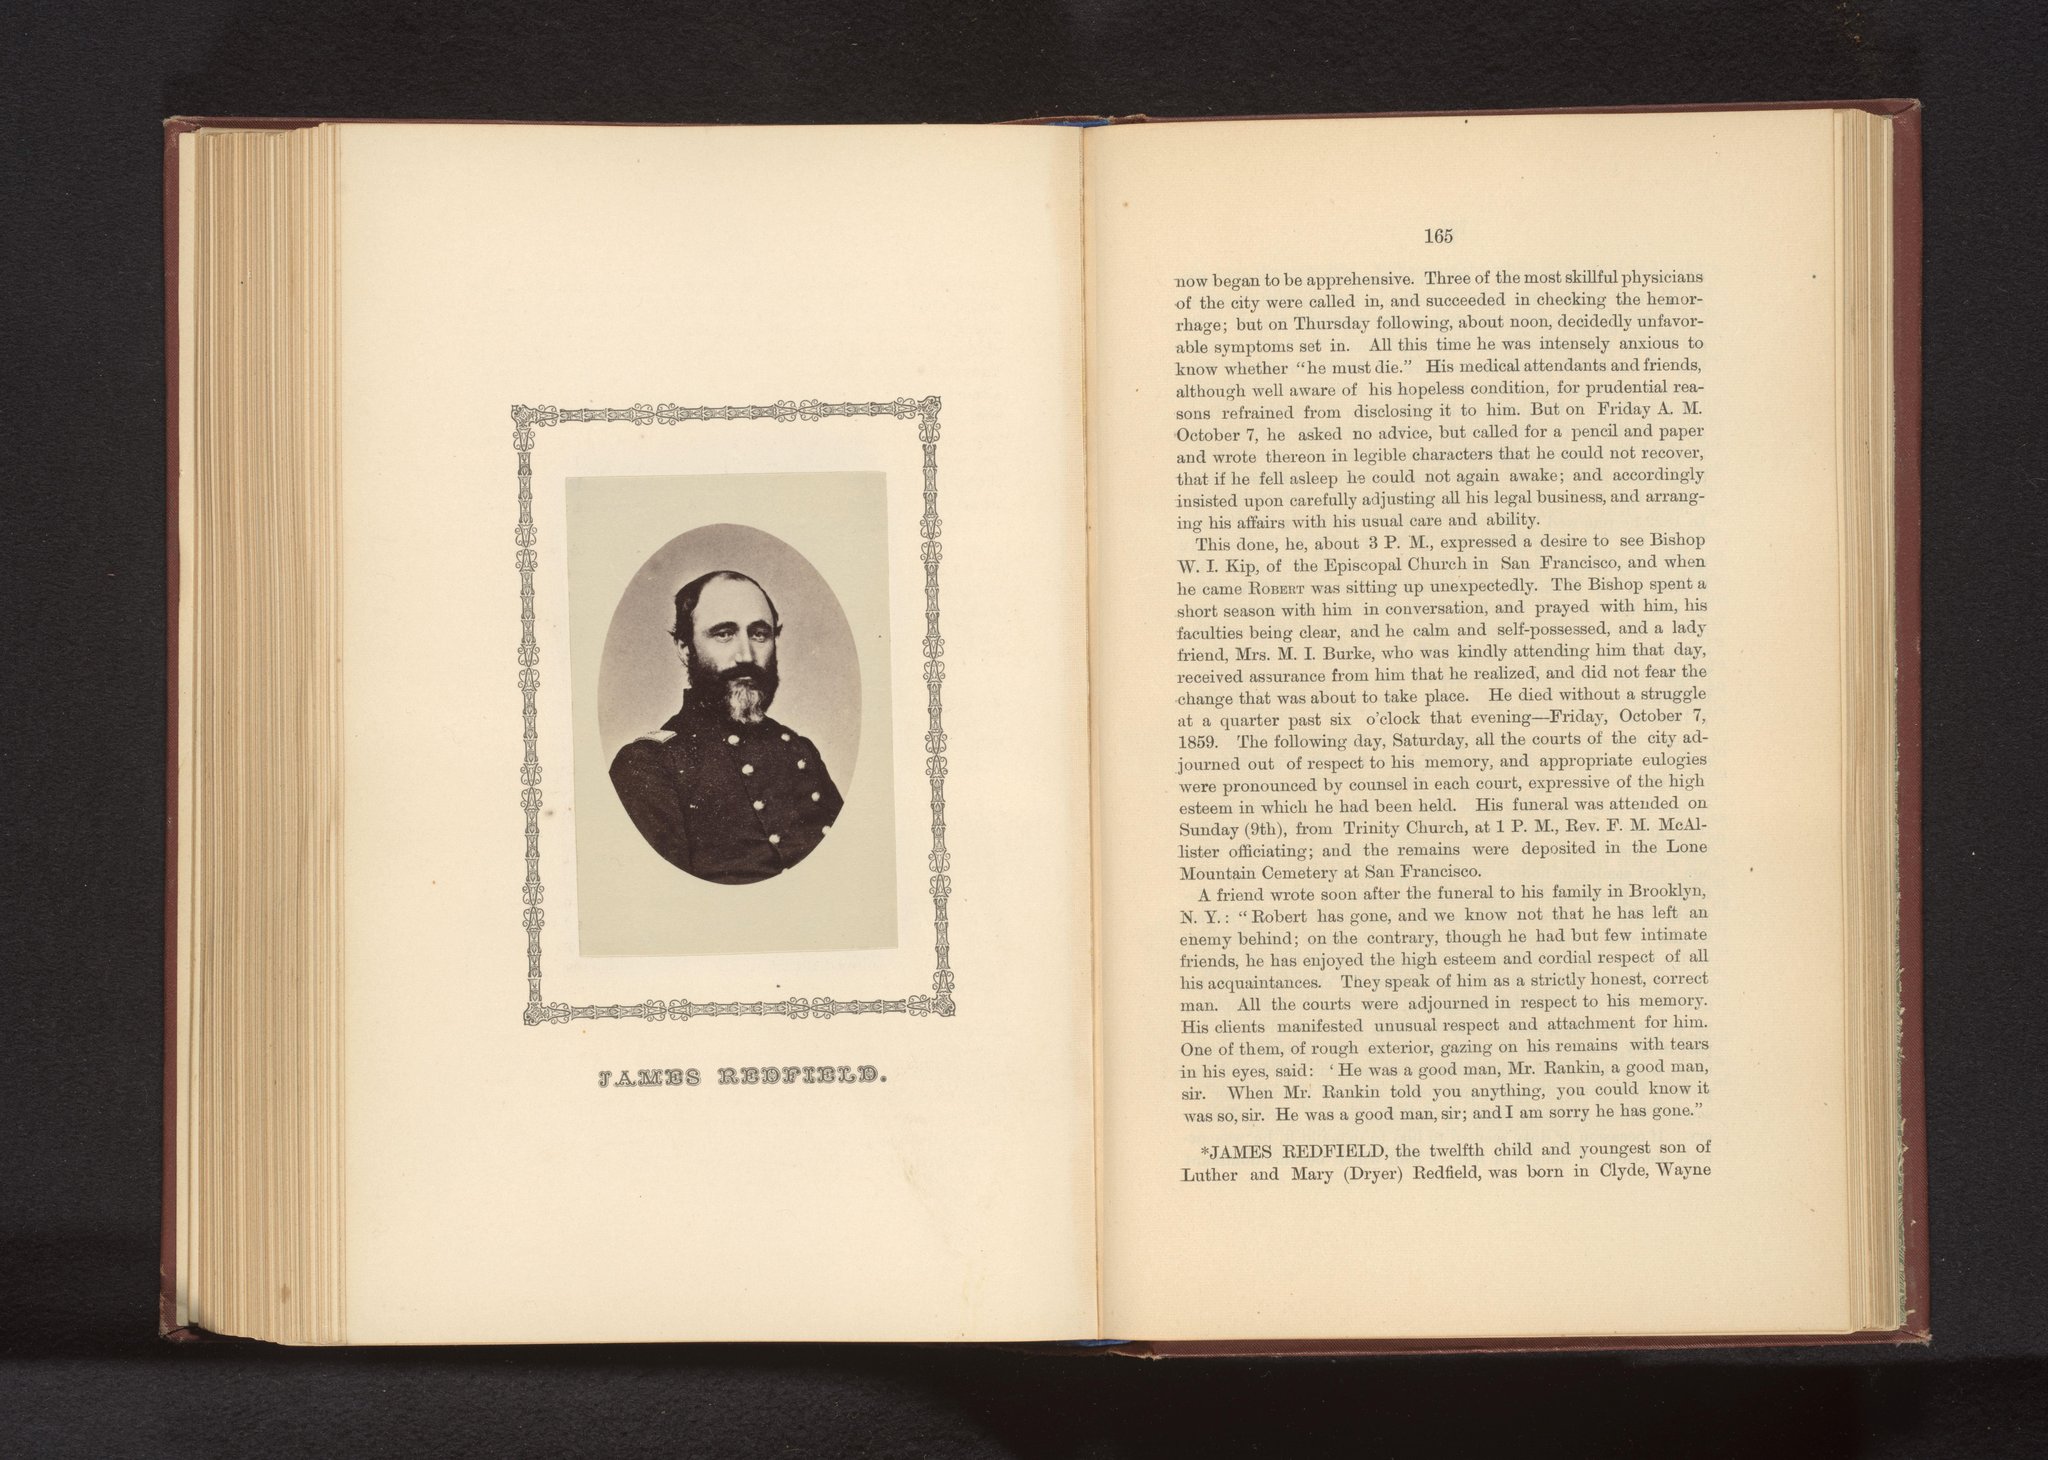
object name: photograph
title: James Redfield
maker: Anonymous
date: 1876-1881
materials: photographic support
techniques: albumen print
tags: adult man